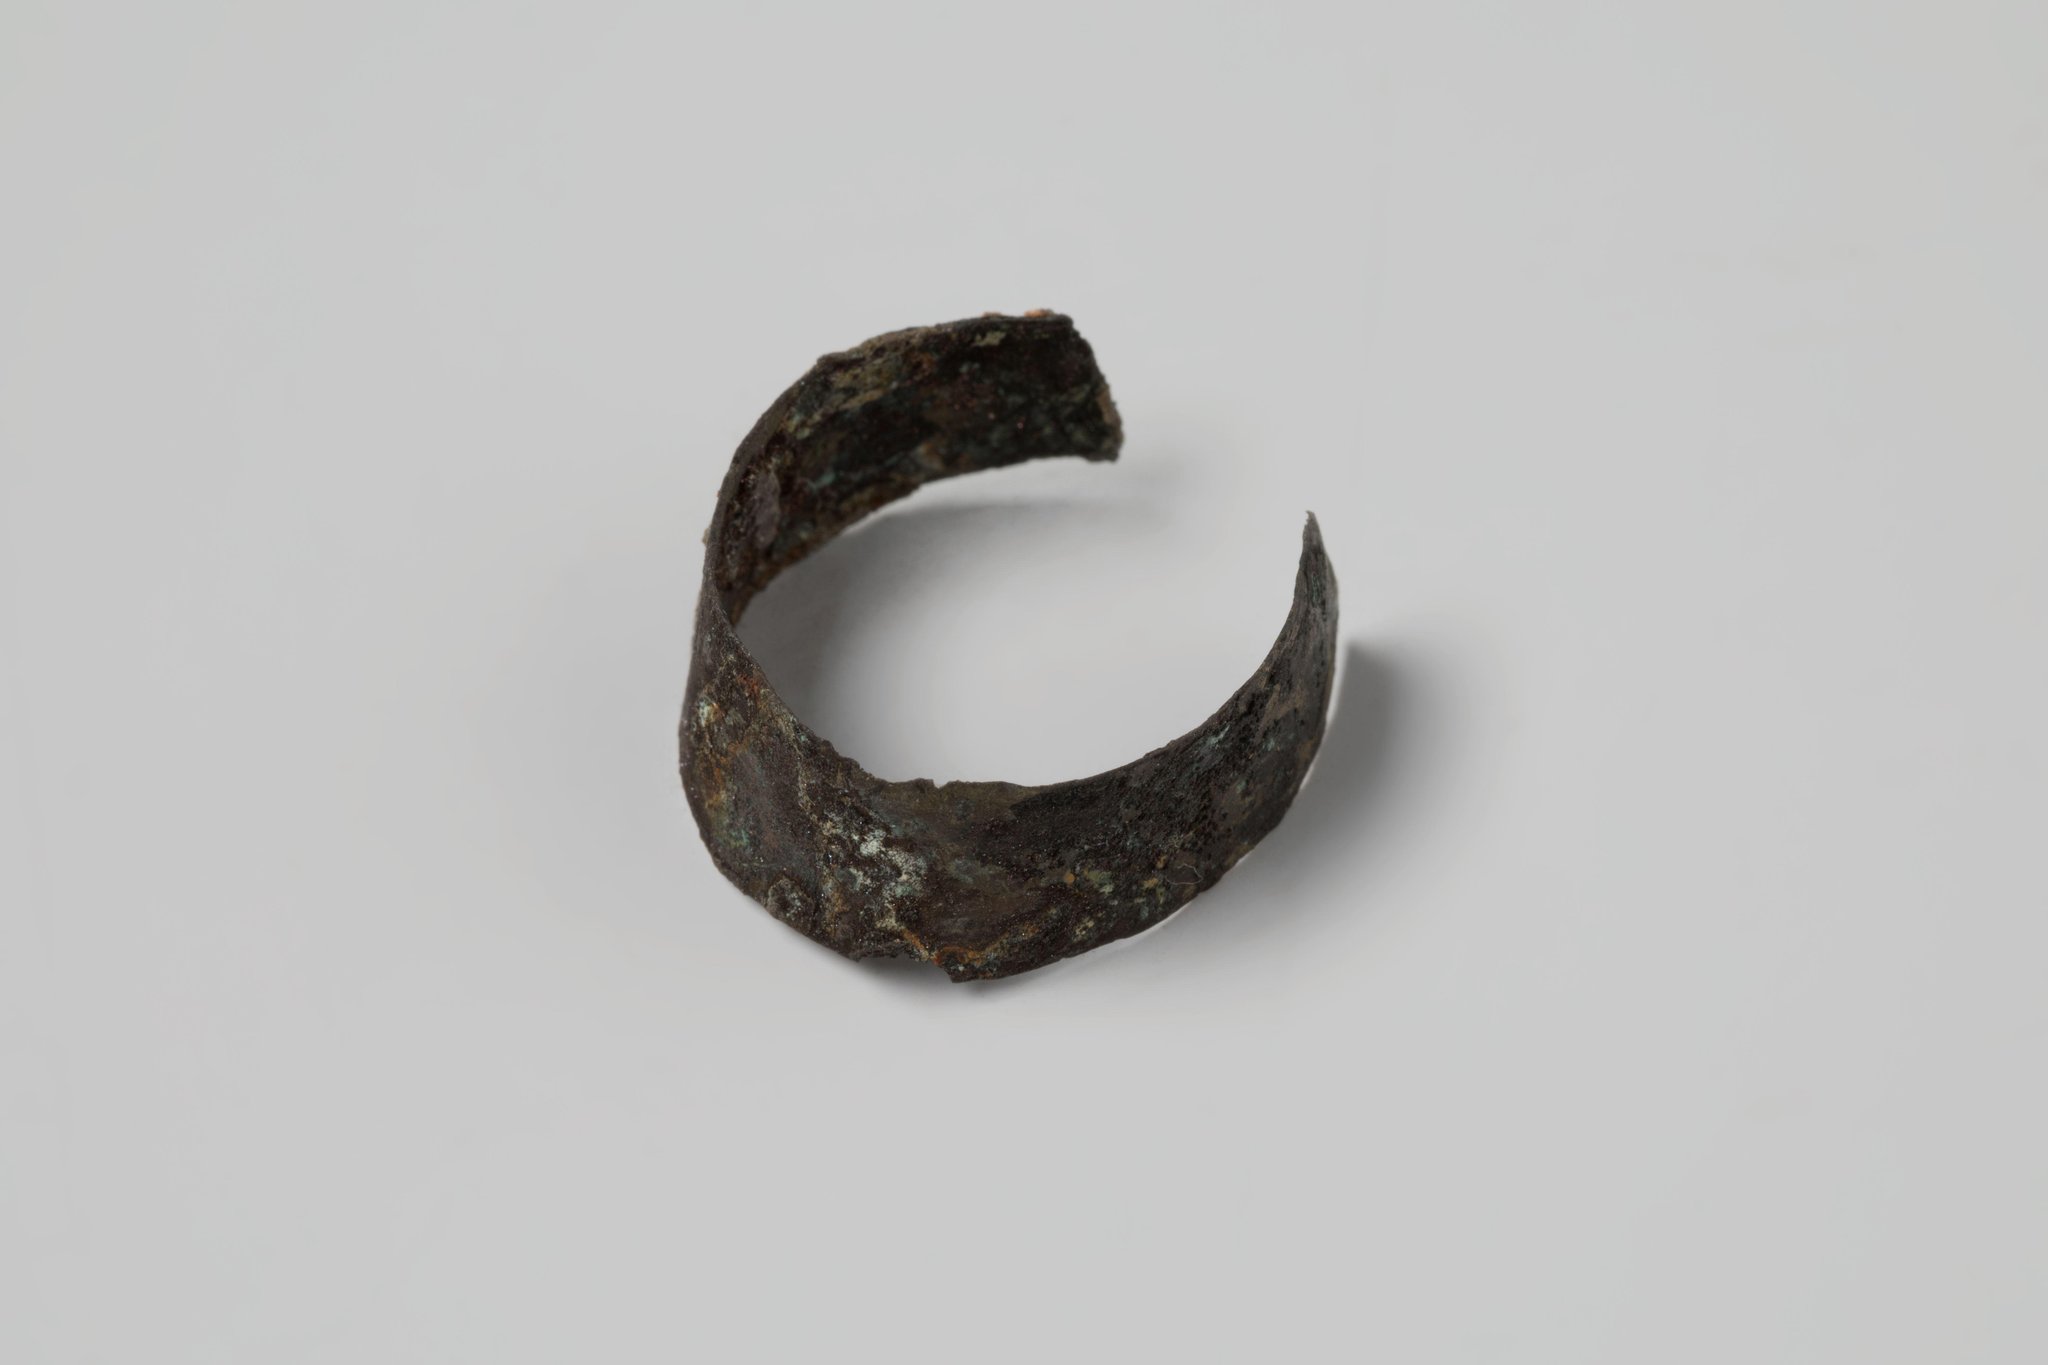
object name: ferrule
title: Messenheftring uit het wrak van de Oost-Indiëvaarder Hollandia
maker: Anonymous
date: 1700-1743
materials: copper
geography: netherlands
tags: verenigde oostindische compagnie, hollandia (schip), annet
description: Knife-handle, ferrule; sim. NG 1980-27H563.